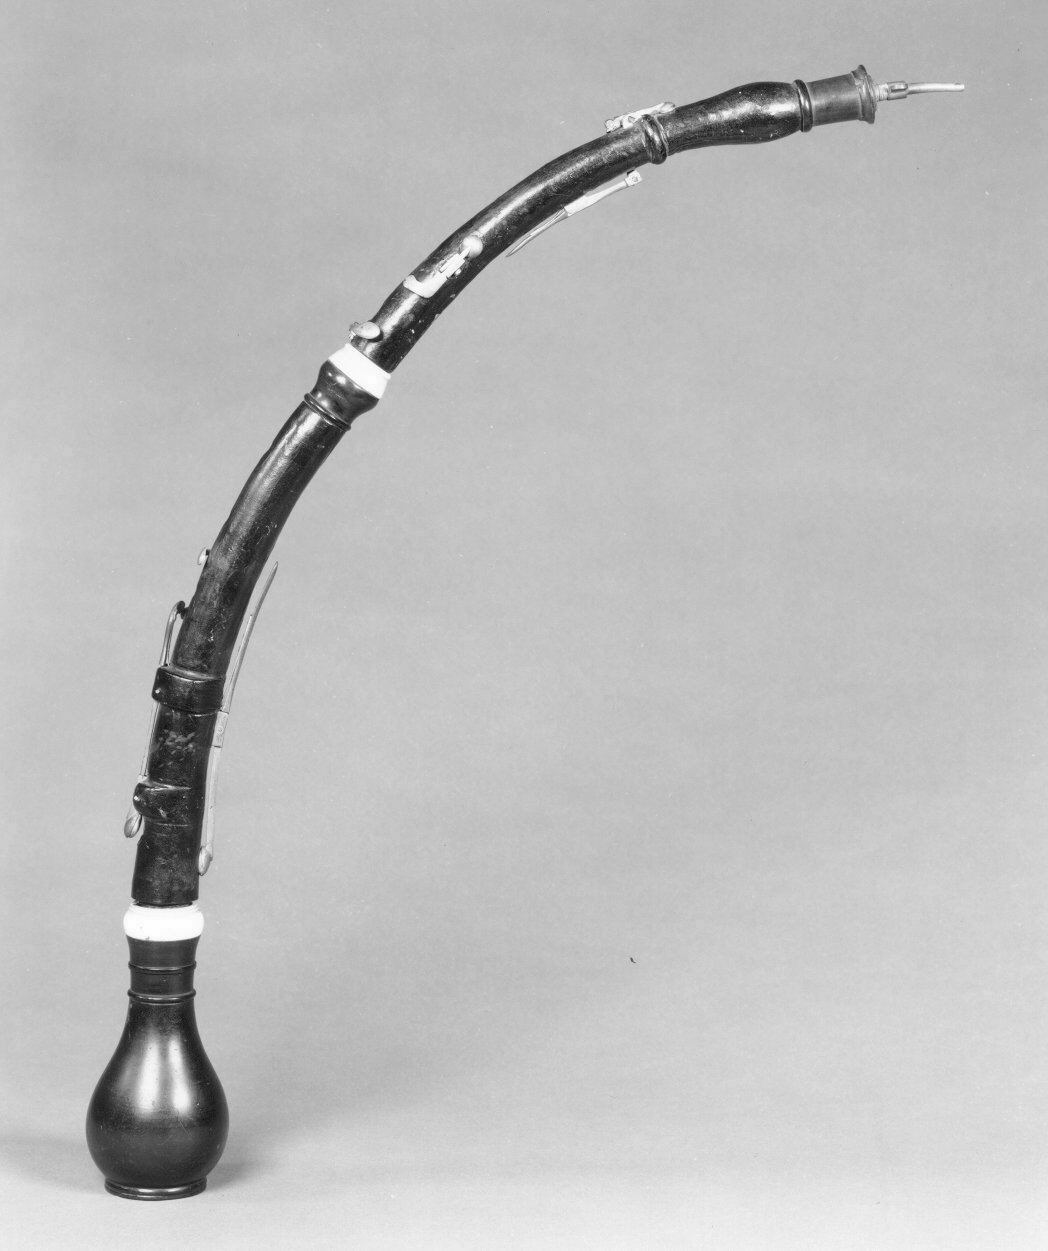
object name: english horn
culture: german or italian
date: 1825-1850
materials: horn, ivory, leather, metal, wood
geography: germany